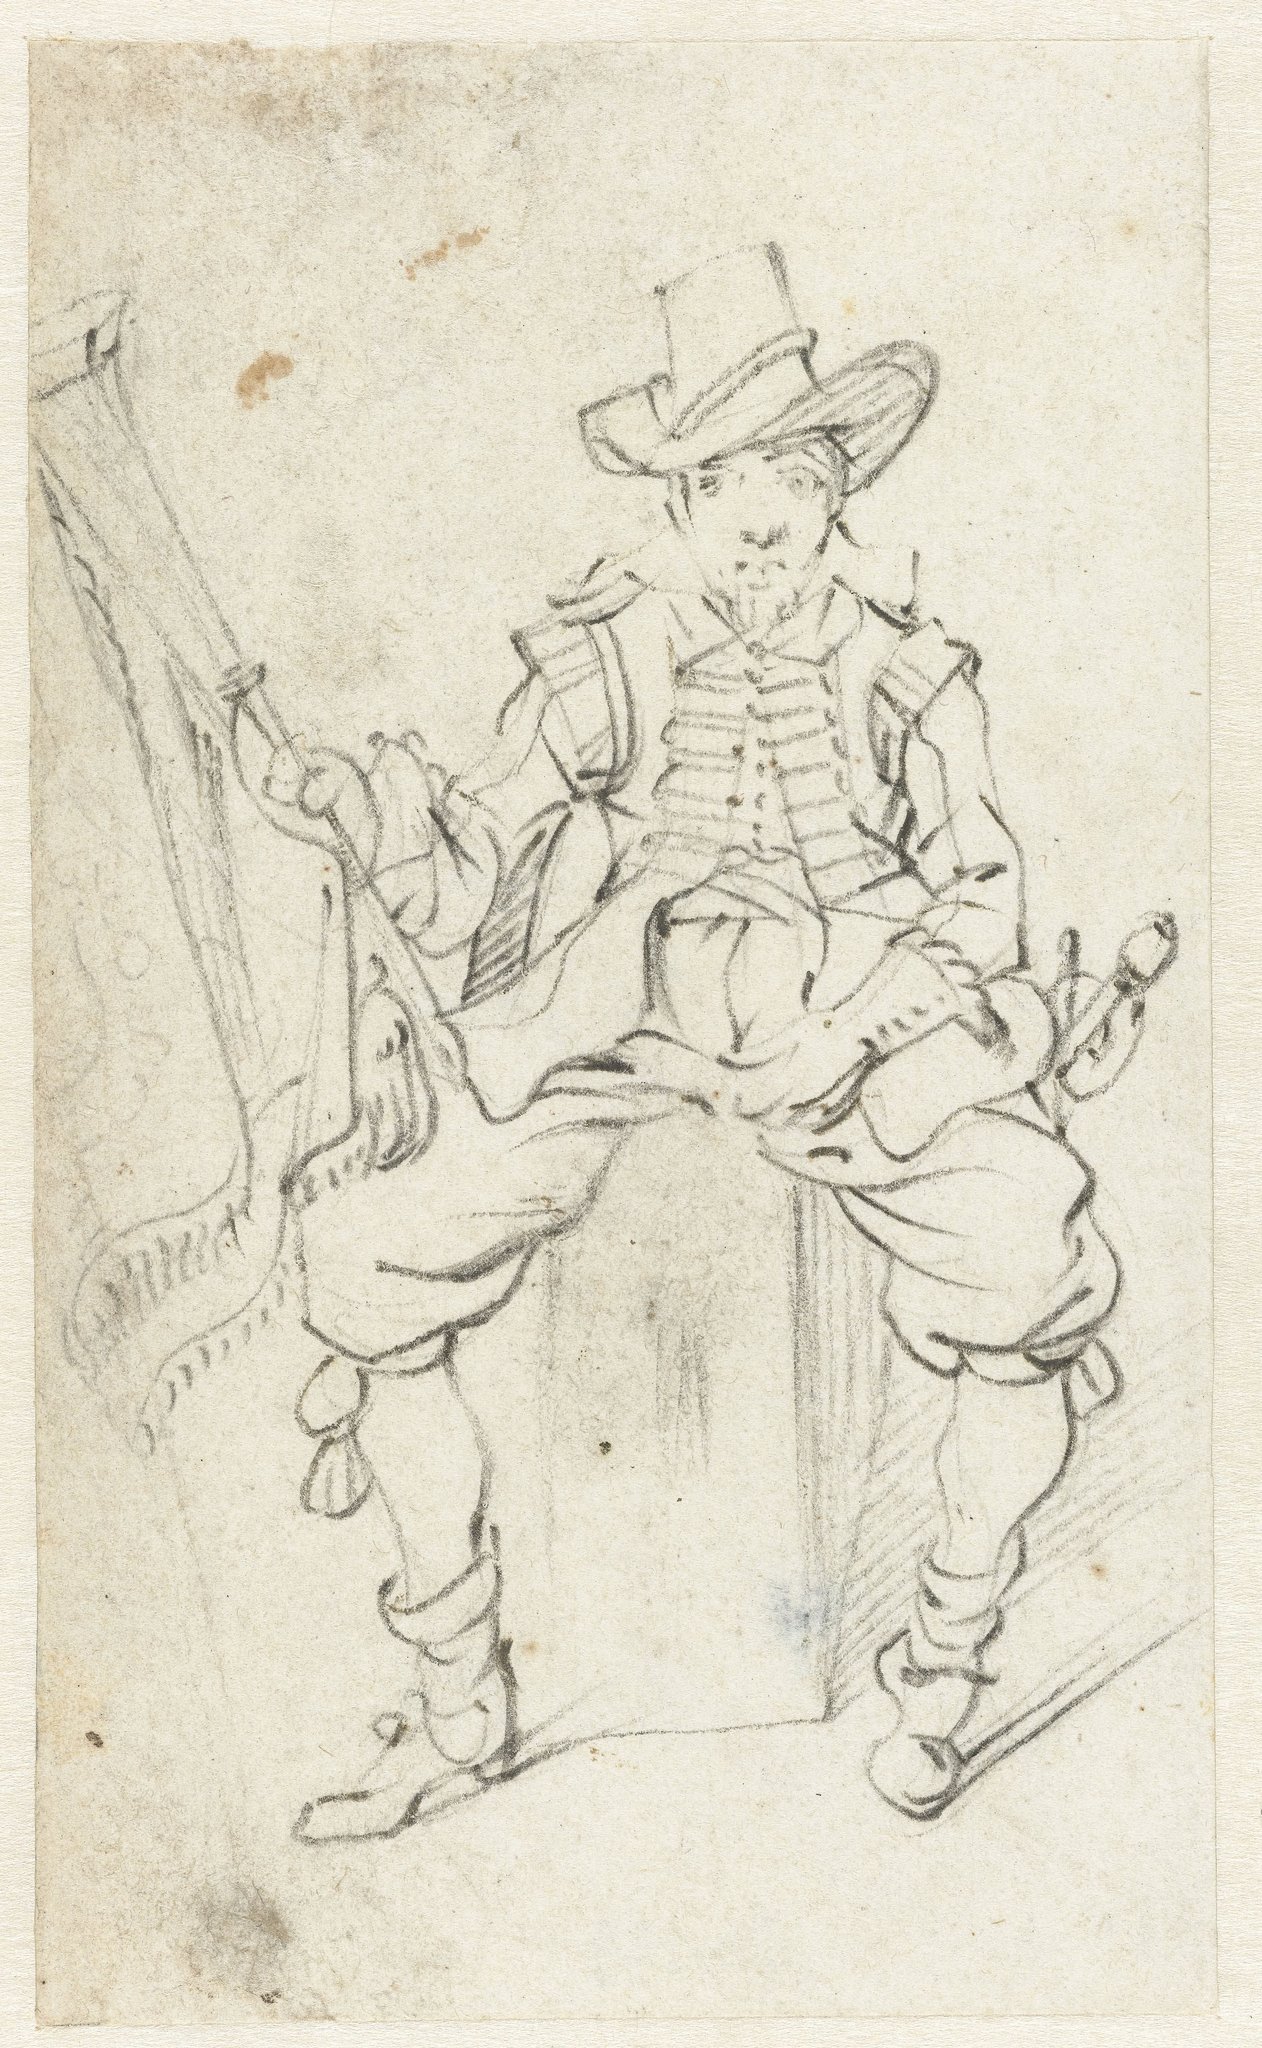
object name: drawing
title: Zittende trompetter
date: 1620-1623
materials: chalk, paper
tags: horn, trumpet, cornet, trombone, tuba, military music, one person with musical instrument, not playing, the soldier; the soldier's life